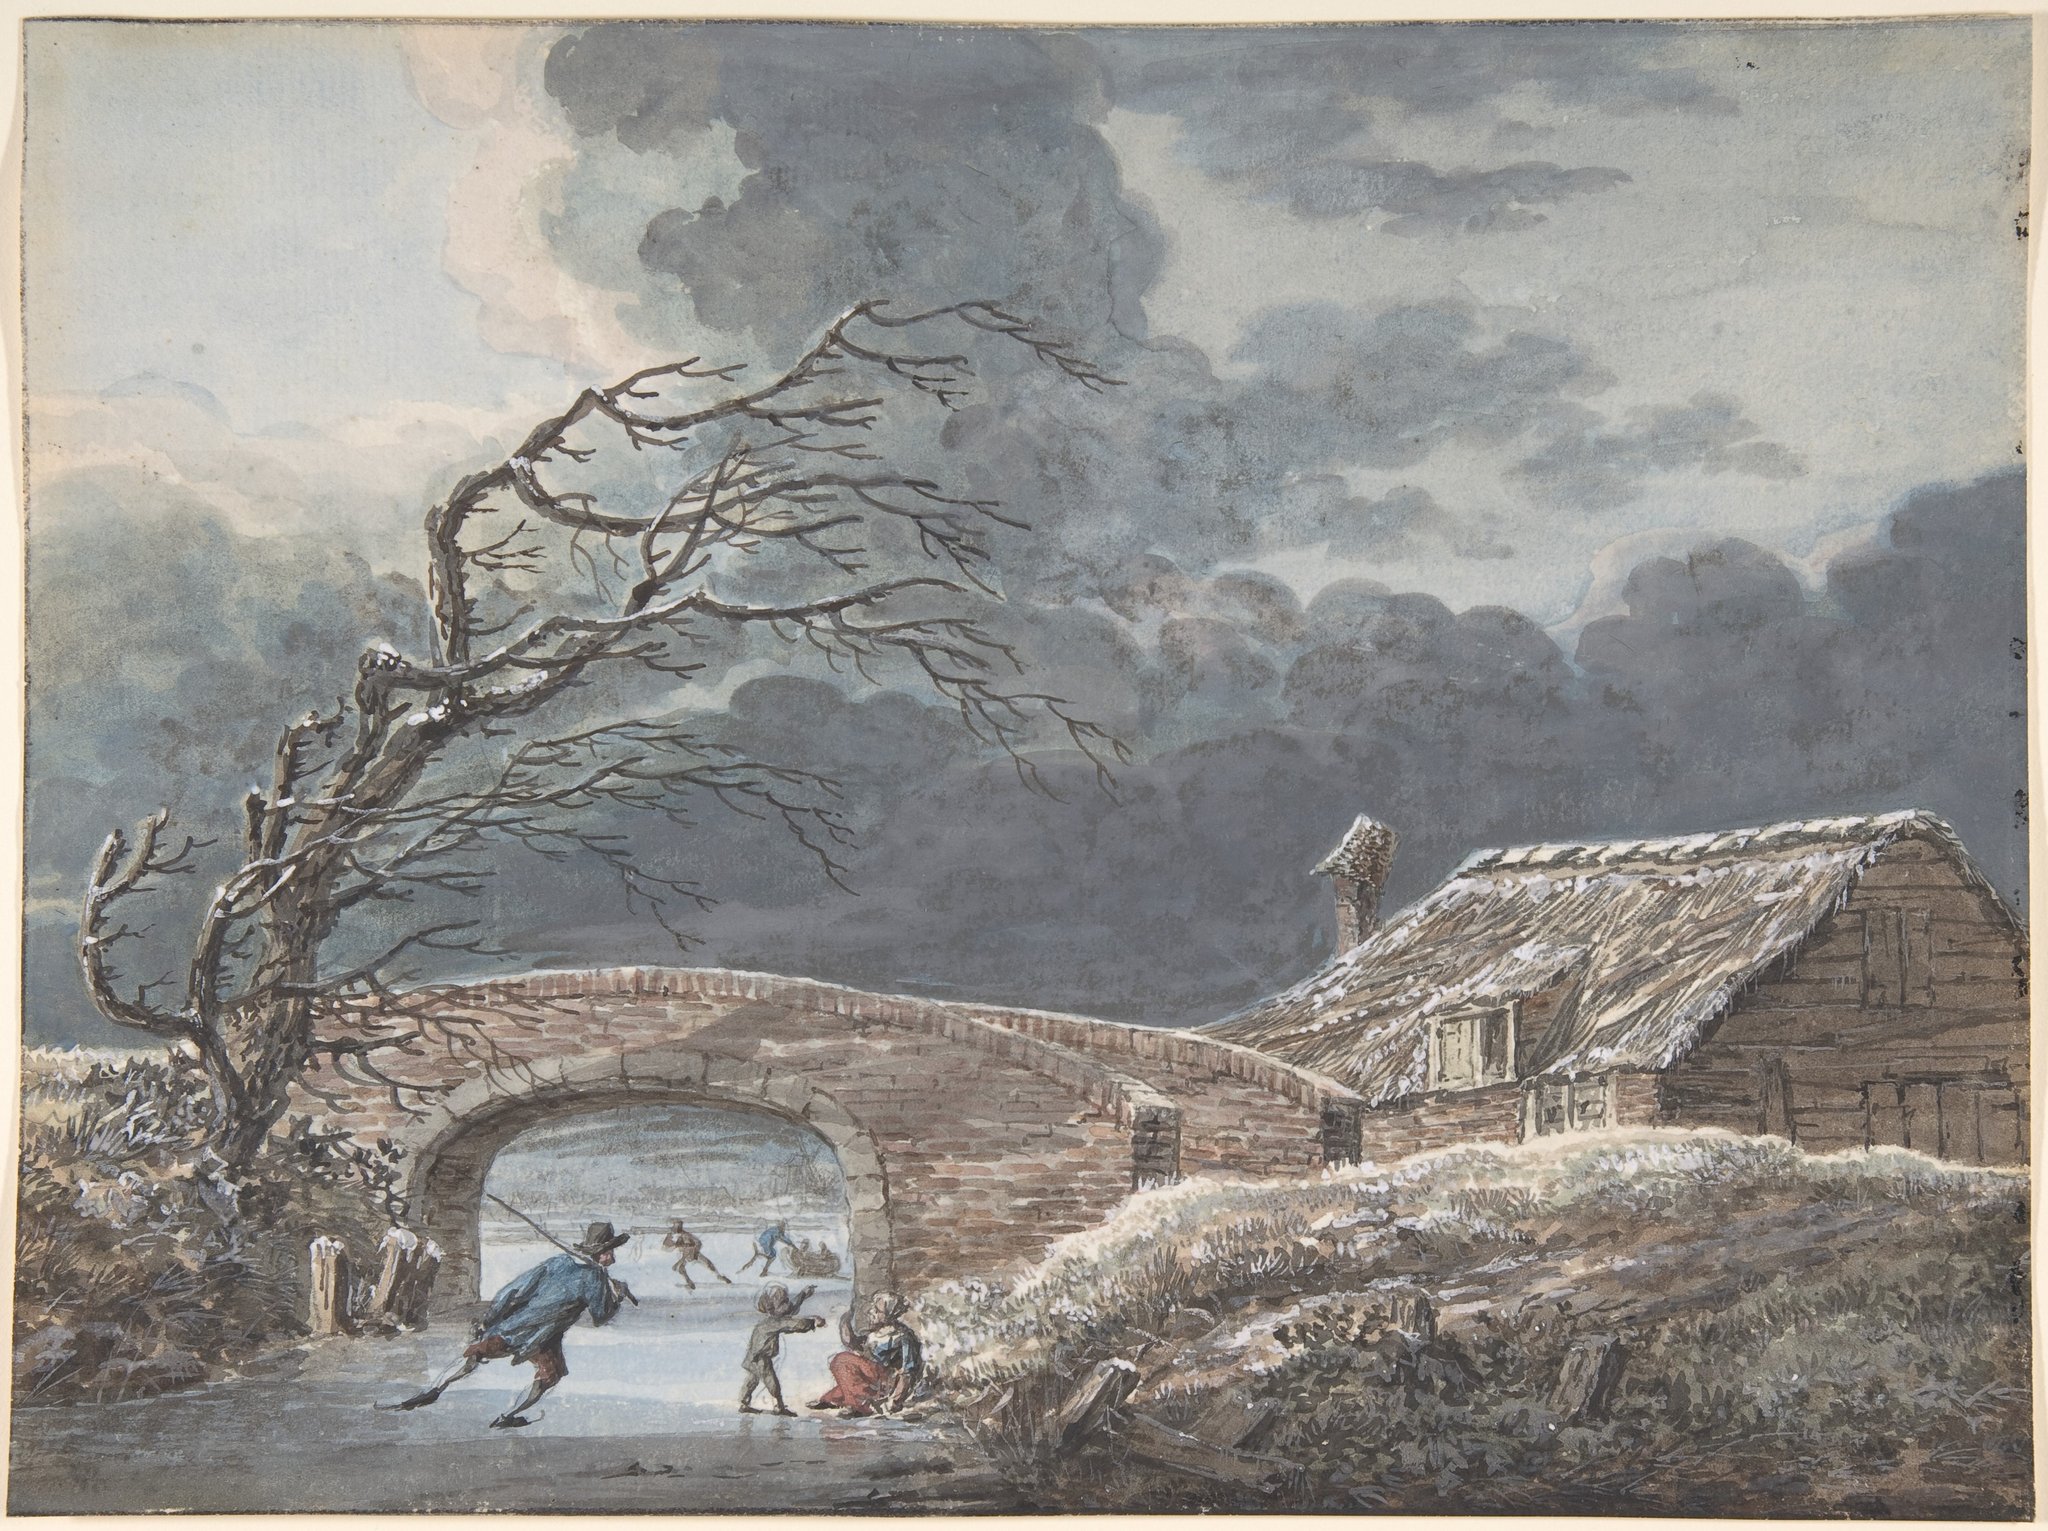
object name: drawing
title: Winter Landscape with Skaters on a Frozen Canal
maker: vincent jansz. van der vinne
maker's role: draughtsman, print maker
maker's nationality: dutch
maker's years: 1736-1811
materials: chalk, watercolor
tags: human figures,houses,bridges,landscapes,trees